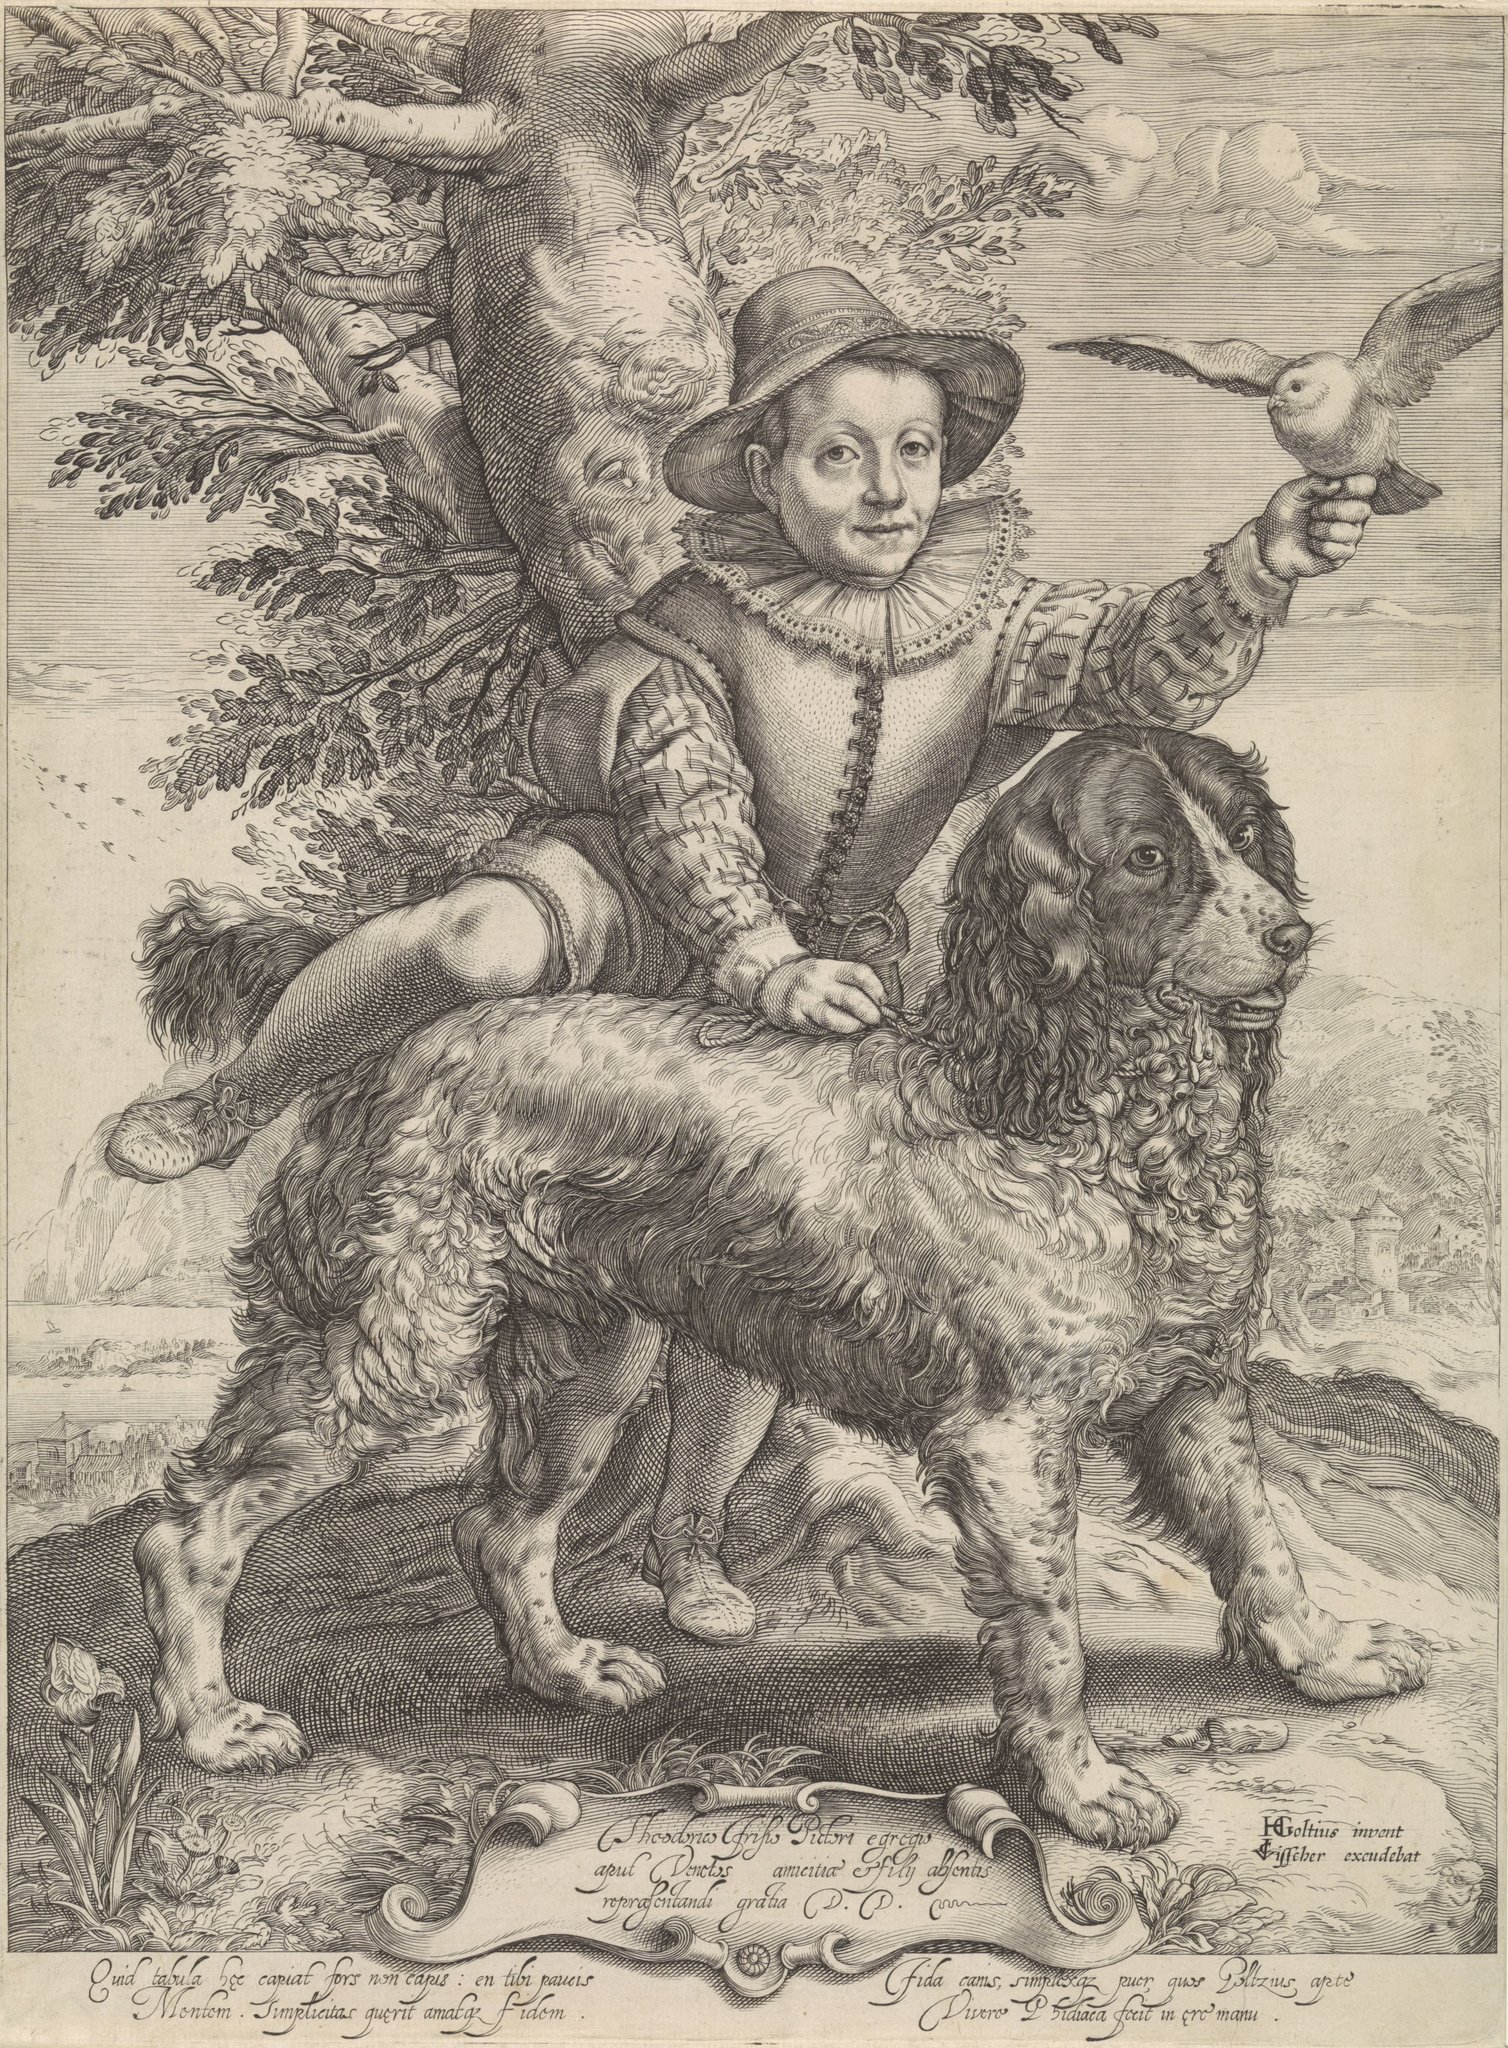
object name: print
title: Portret van Frederik de Vries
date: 1601-1652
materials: paper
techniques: engraving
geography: amsterdam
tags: dog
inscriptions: collector's mark: Lugt 2166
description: Portret van Frederik de Vries met de hond van Hendrick Goltzius. Hij was een zoon van de schilder Dirck de Vries, die een leerling was van Hendrick Goltzius. Frederik maakt aanstalten om op de rug van de hond te gaan zitten en houdt een duif in de hand. Op het cartouche een opdracht in het Latijn. Het onderschrift in het Latijn spreekt over de eenvoud van het kind en de trouw van de hond.